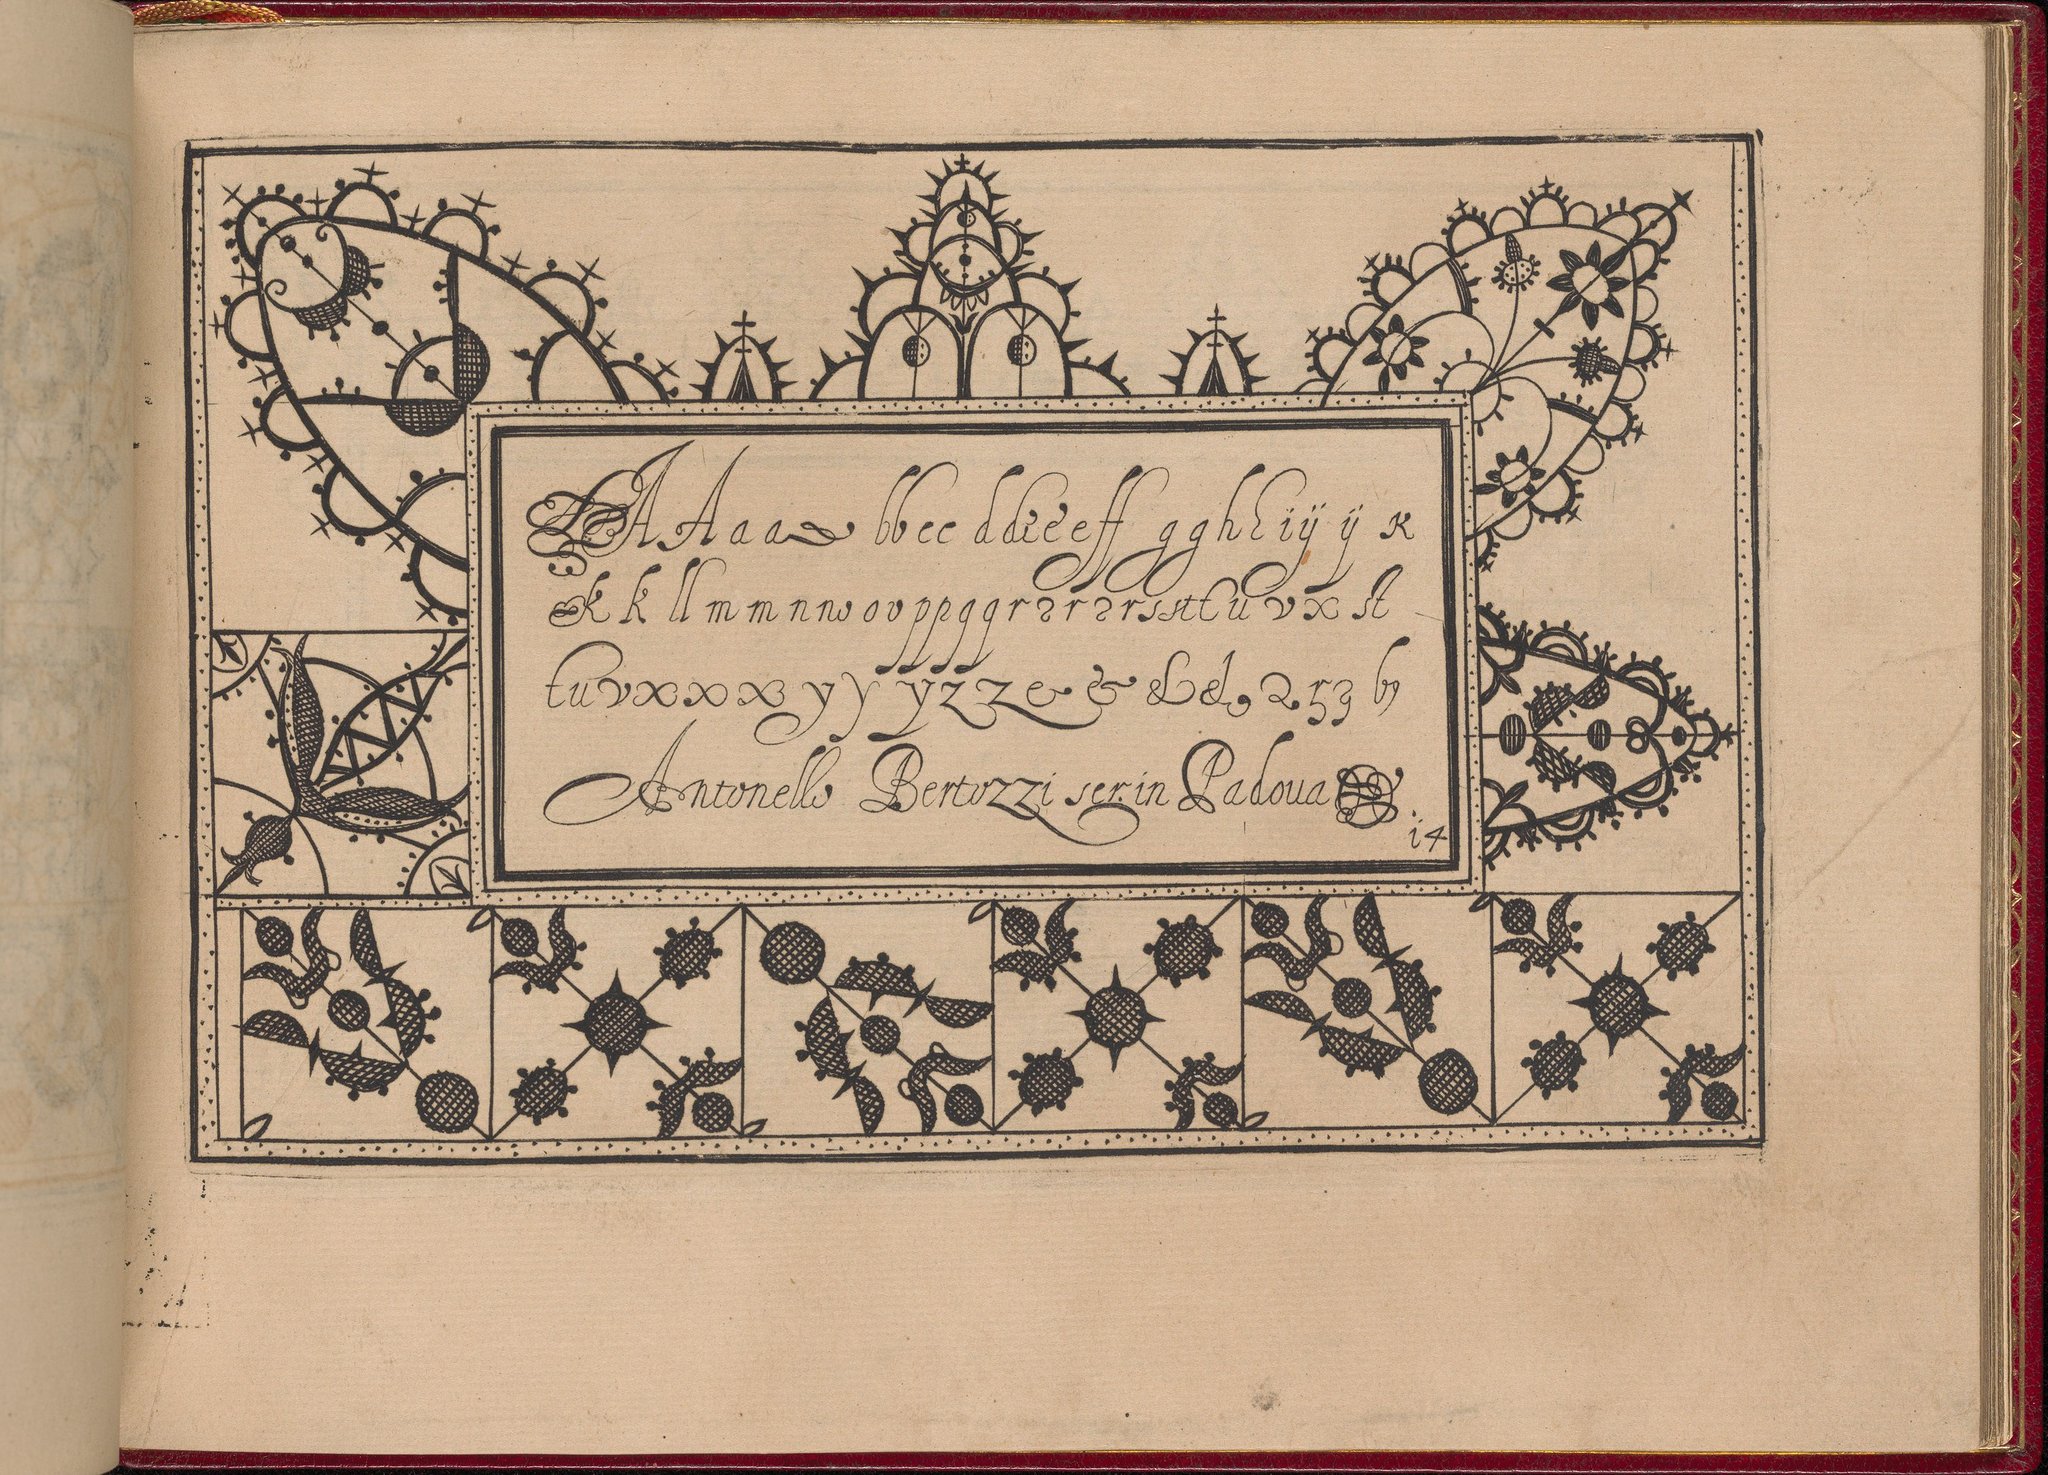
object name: book print ornament architecture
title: Ghirlanda: Di sei vaghi fiori scielti da piu famosi Giardini d'Italia, page 22 (recto)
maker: pietro paulo tozzi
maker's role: designer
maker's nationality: italian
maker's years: 1593-1628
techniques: drawing, etching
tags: ornament